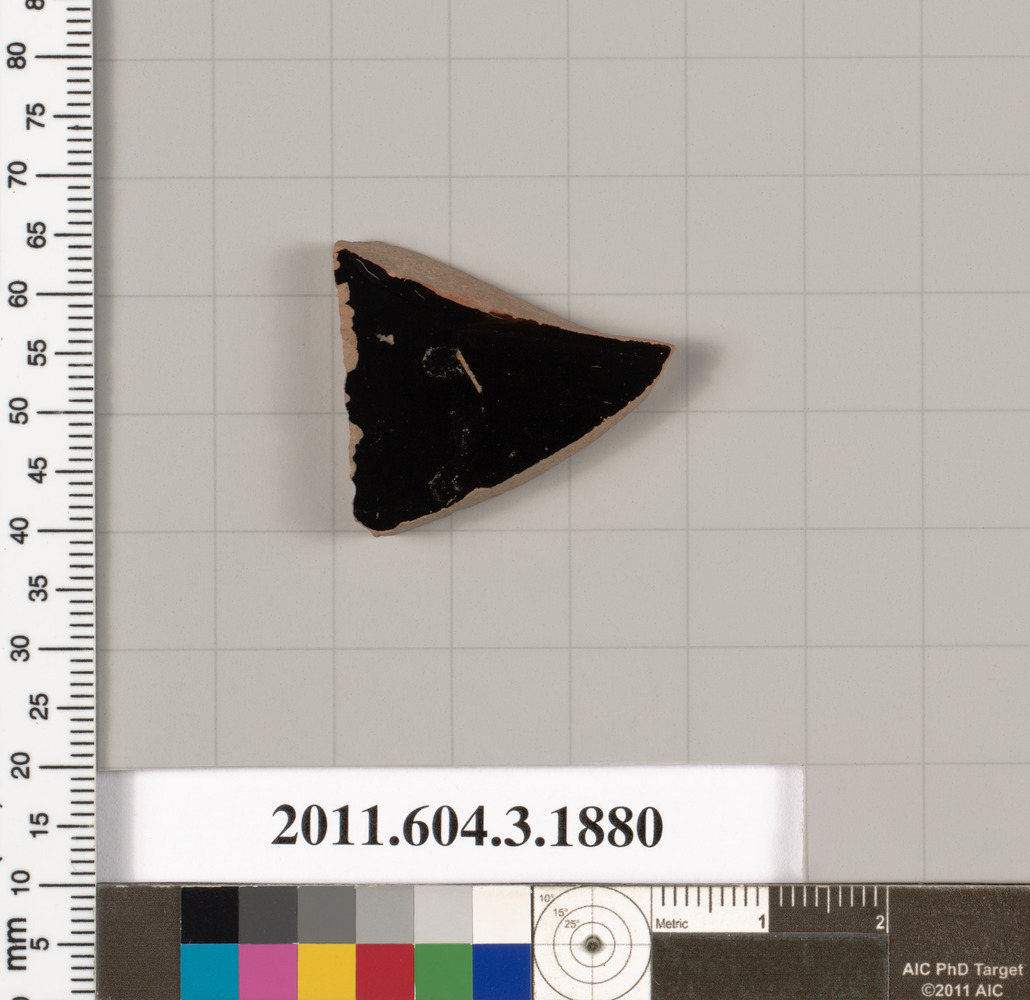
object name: kylix fragment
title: Terracotta fragment of a kylix (drinking cup)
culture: greek, attic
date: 560-525 BCE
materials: terracotta